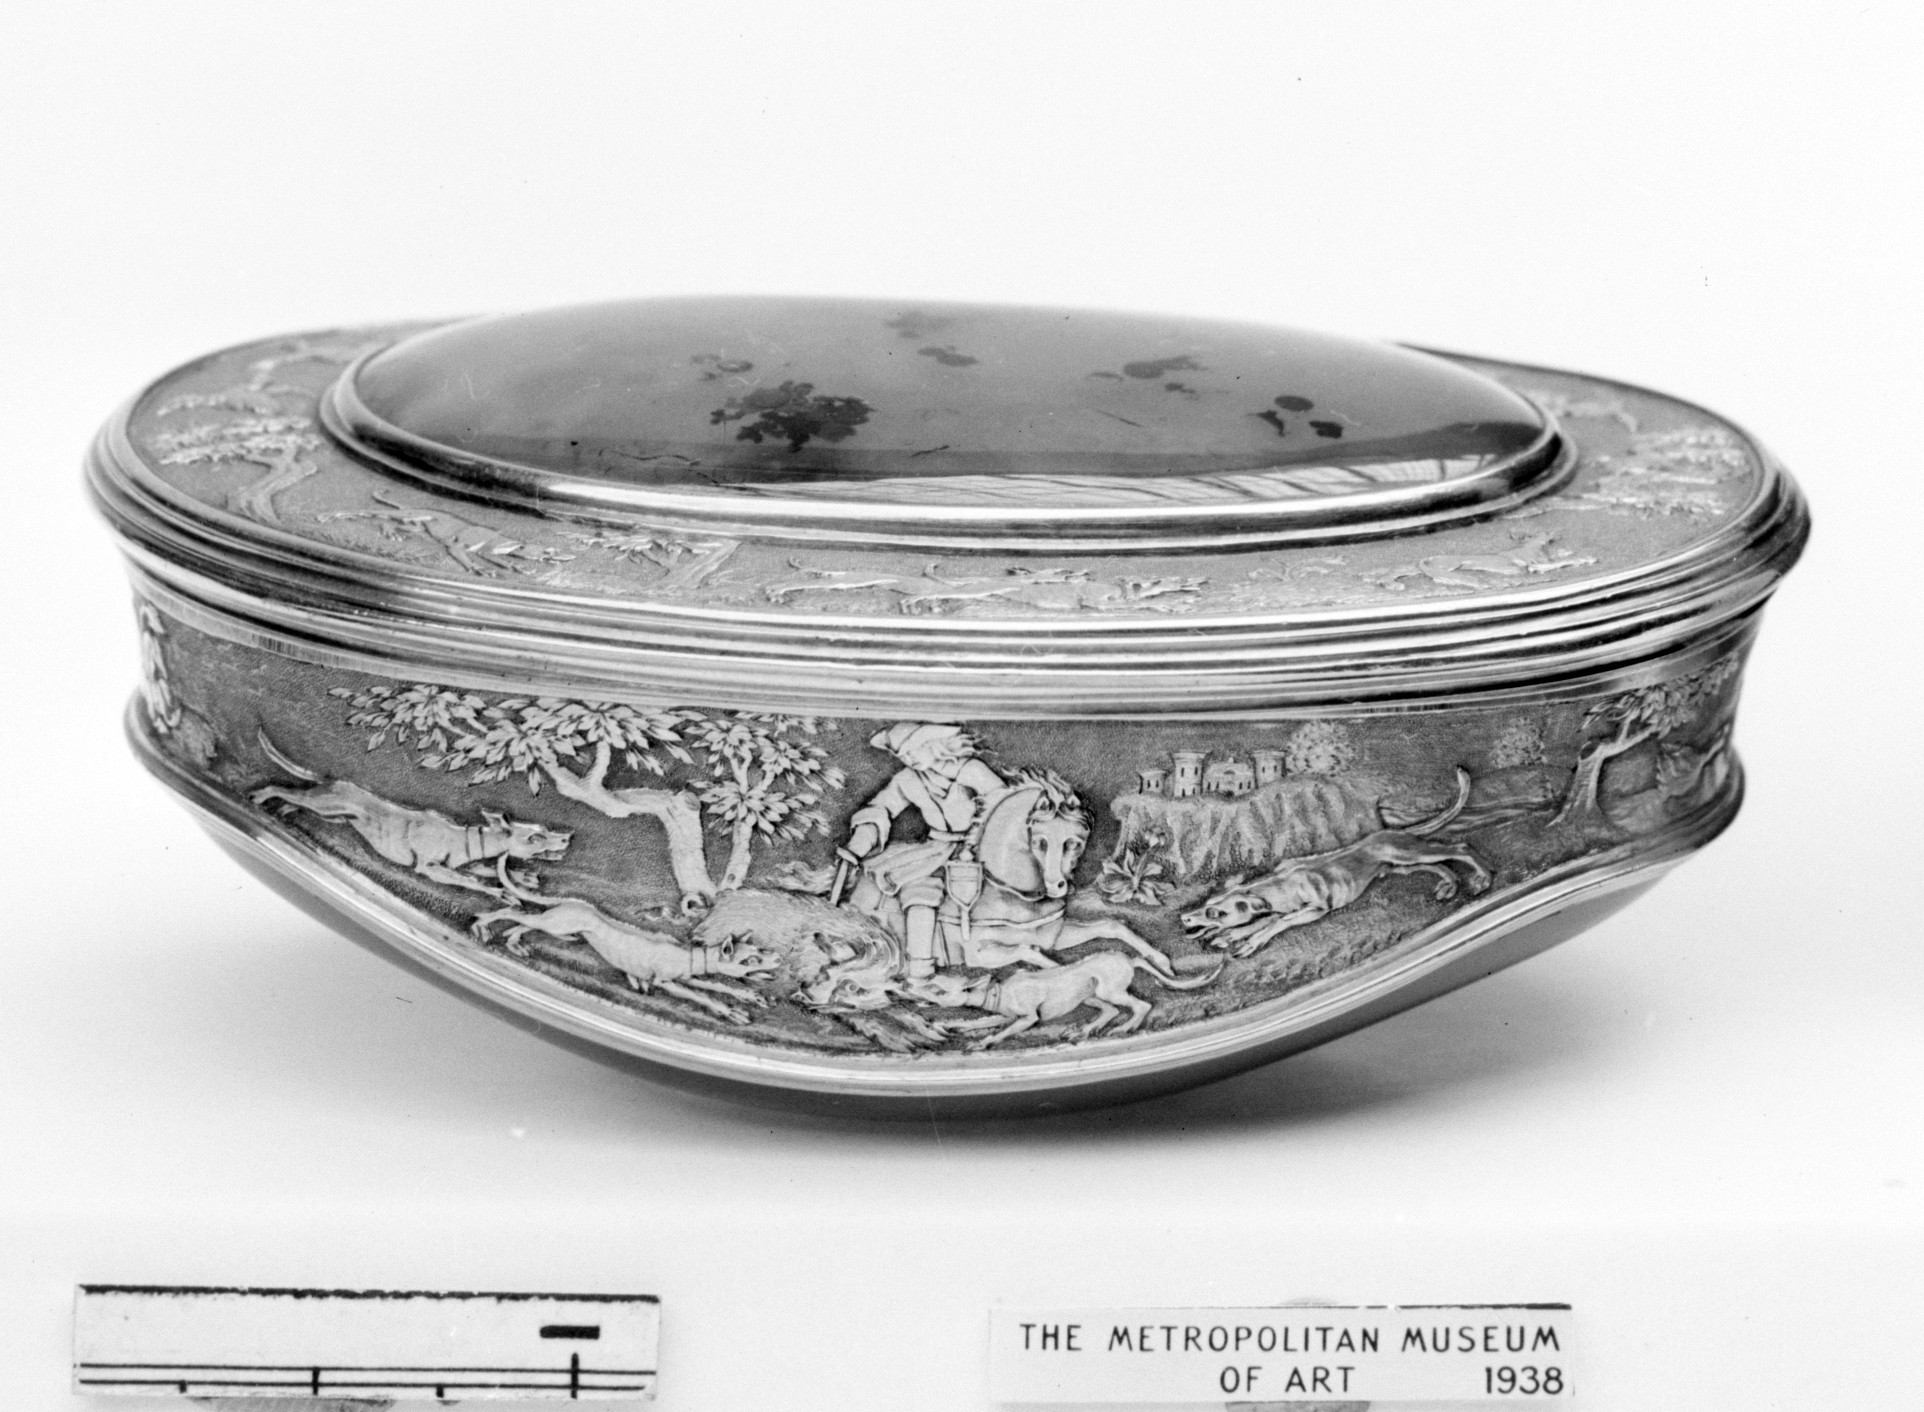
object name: snuffbox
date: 1730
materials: stone, gold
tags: buildings,men,hunting,boars,dogs,horses,hills,trees